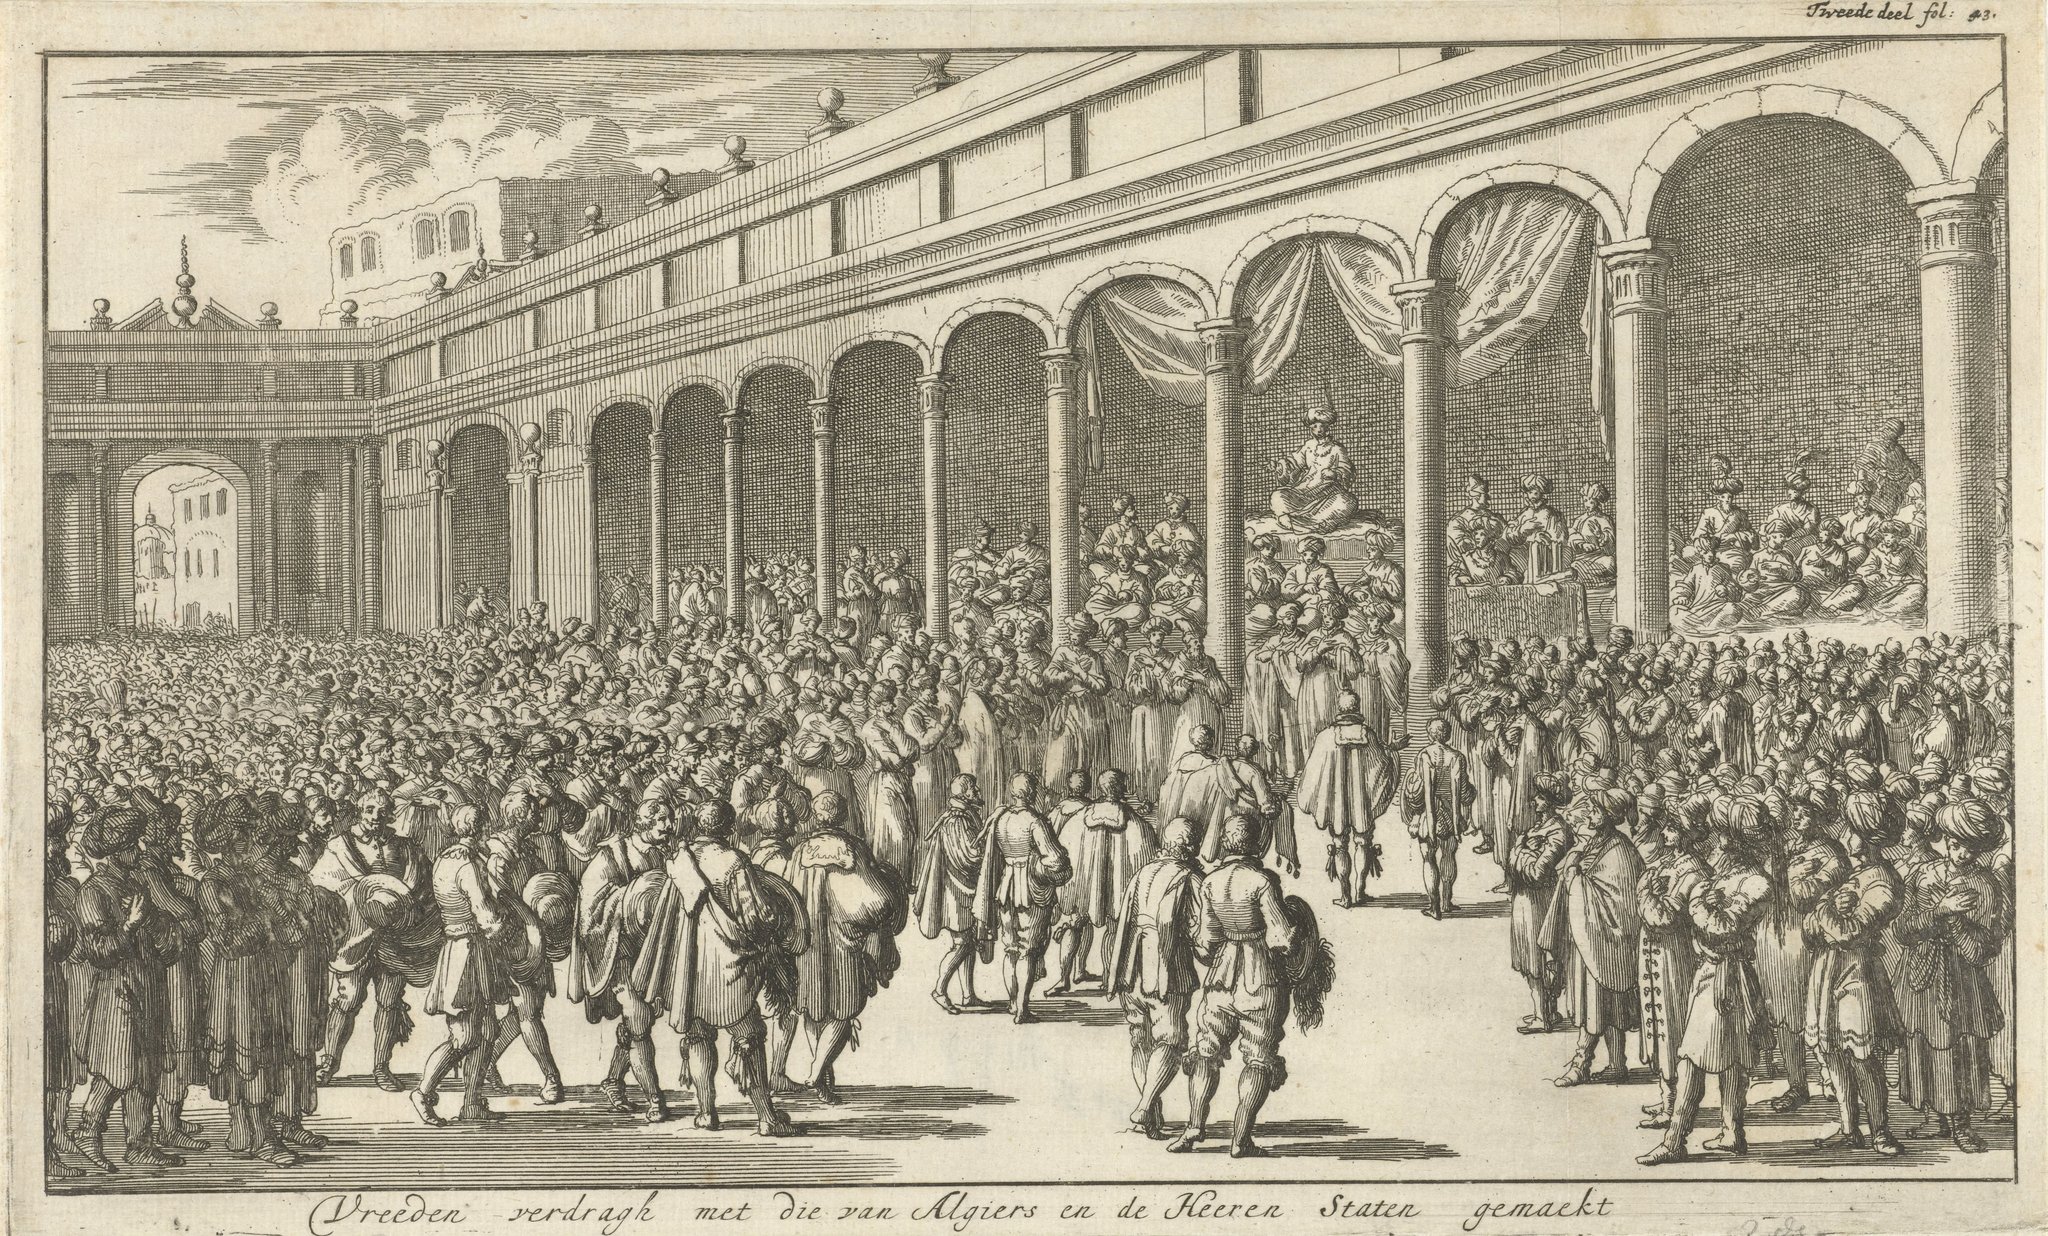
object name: print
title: Asan Aga spreekt westerlingen in aanwezigheid van een grote menigte mensen op een plein toe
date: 1684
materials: paper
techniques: engraving, etching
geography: amsterdam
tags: cornelis pijnacker, pirate, corsair, buccaneer, square, place, circus, etc., peace negotiations, slavery; serfs and enslaved persons, ruler, sovereign, signing of peace treaty, concluding the peace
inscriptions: collector's mark: Lugt 2228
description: Prent uit: Vries, Simon de. Handelingen en geschiedenissen voorgevallen tusschen den Staet der Vereenighde Nederlanden en dien van de zee-roovers in Barbaryen (...). Amsterdam: Jan Claesz ten Hoorn, 1684, p. 43. Uitgegeven als het tweede deel van: Dan, Pierre. Historie van Barbaryen, en des zelfs zee-roovers (...). 2 dln. Amsterdam: Jan Claesz ten Hoorn, 1684. Muller plaatst deze gebeurtenis in 1623, maar het vond plaats in 1622.